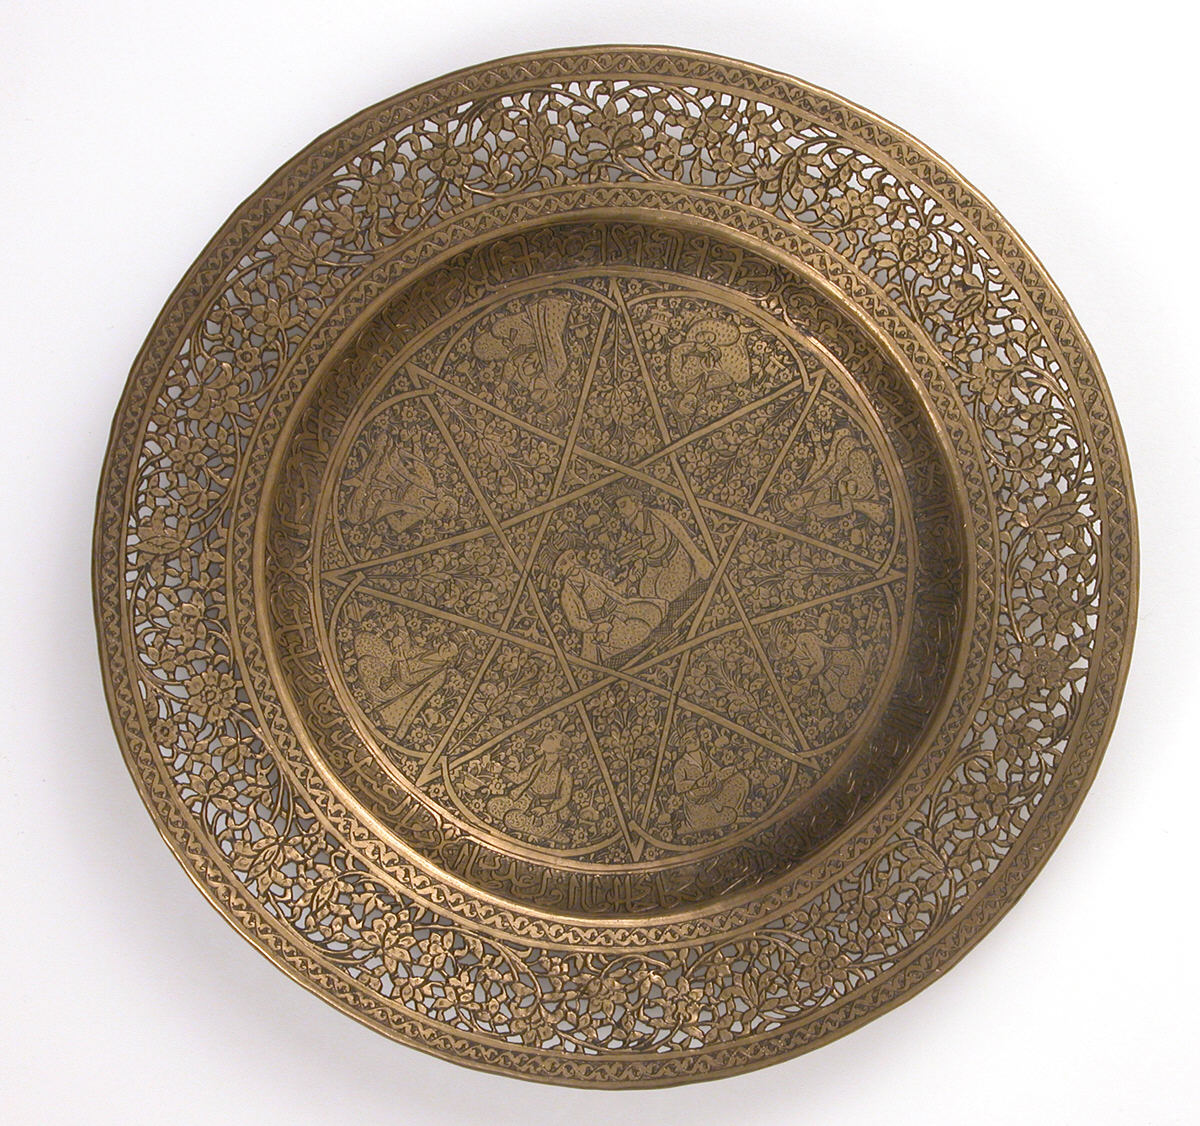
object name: plate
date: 1701-1800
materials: brass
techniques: engraving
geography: iran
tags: men